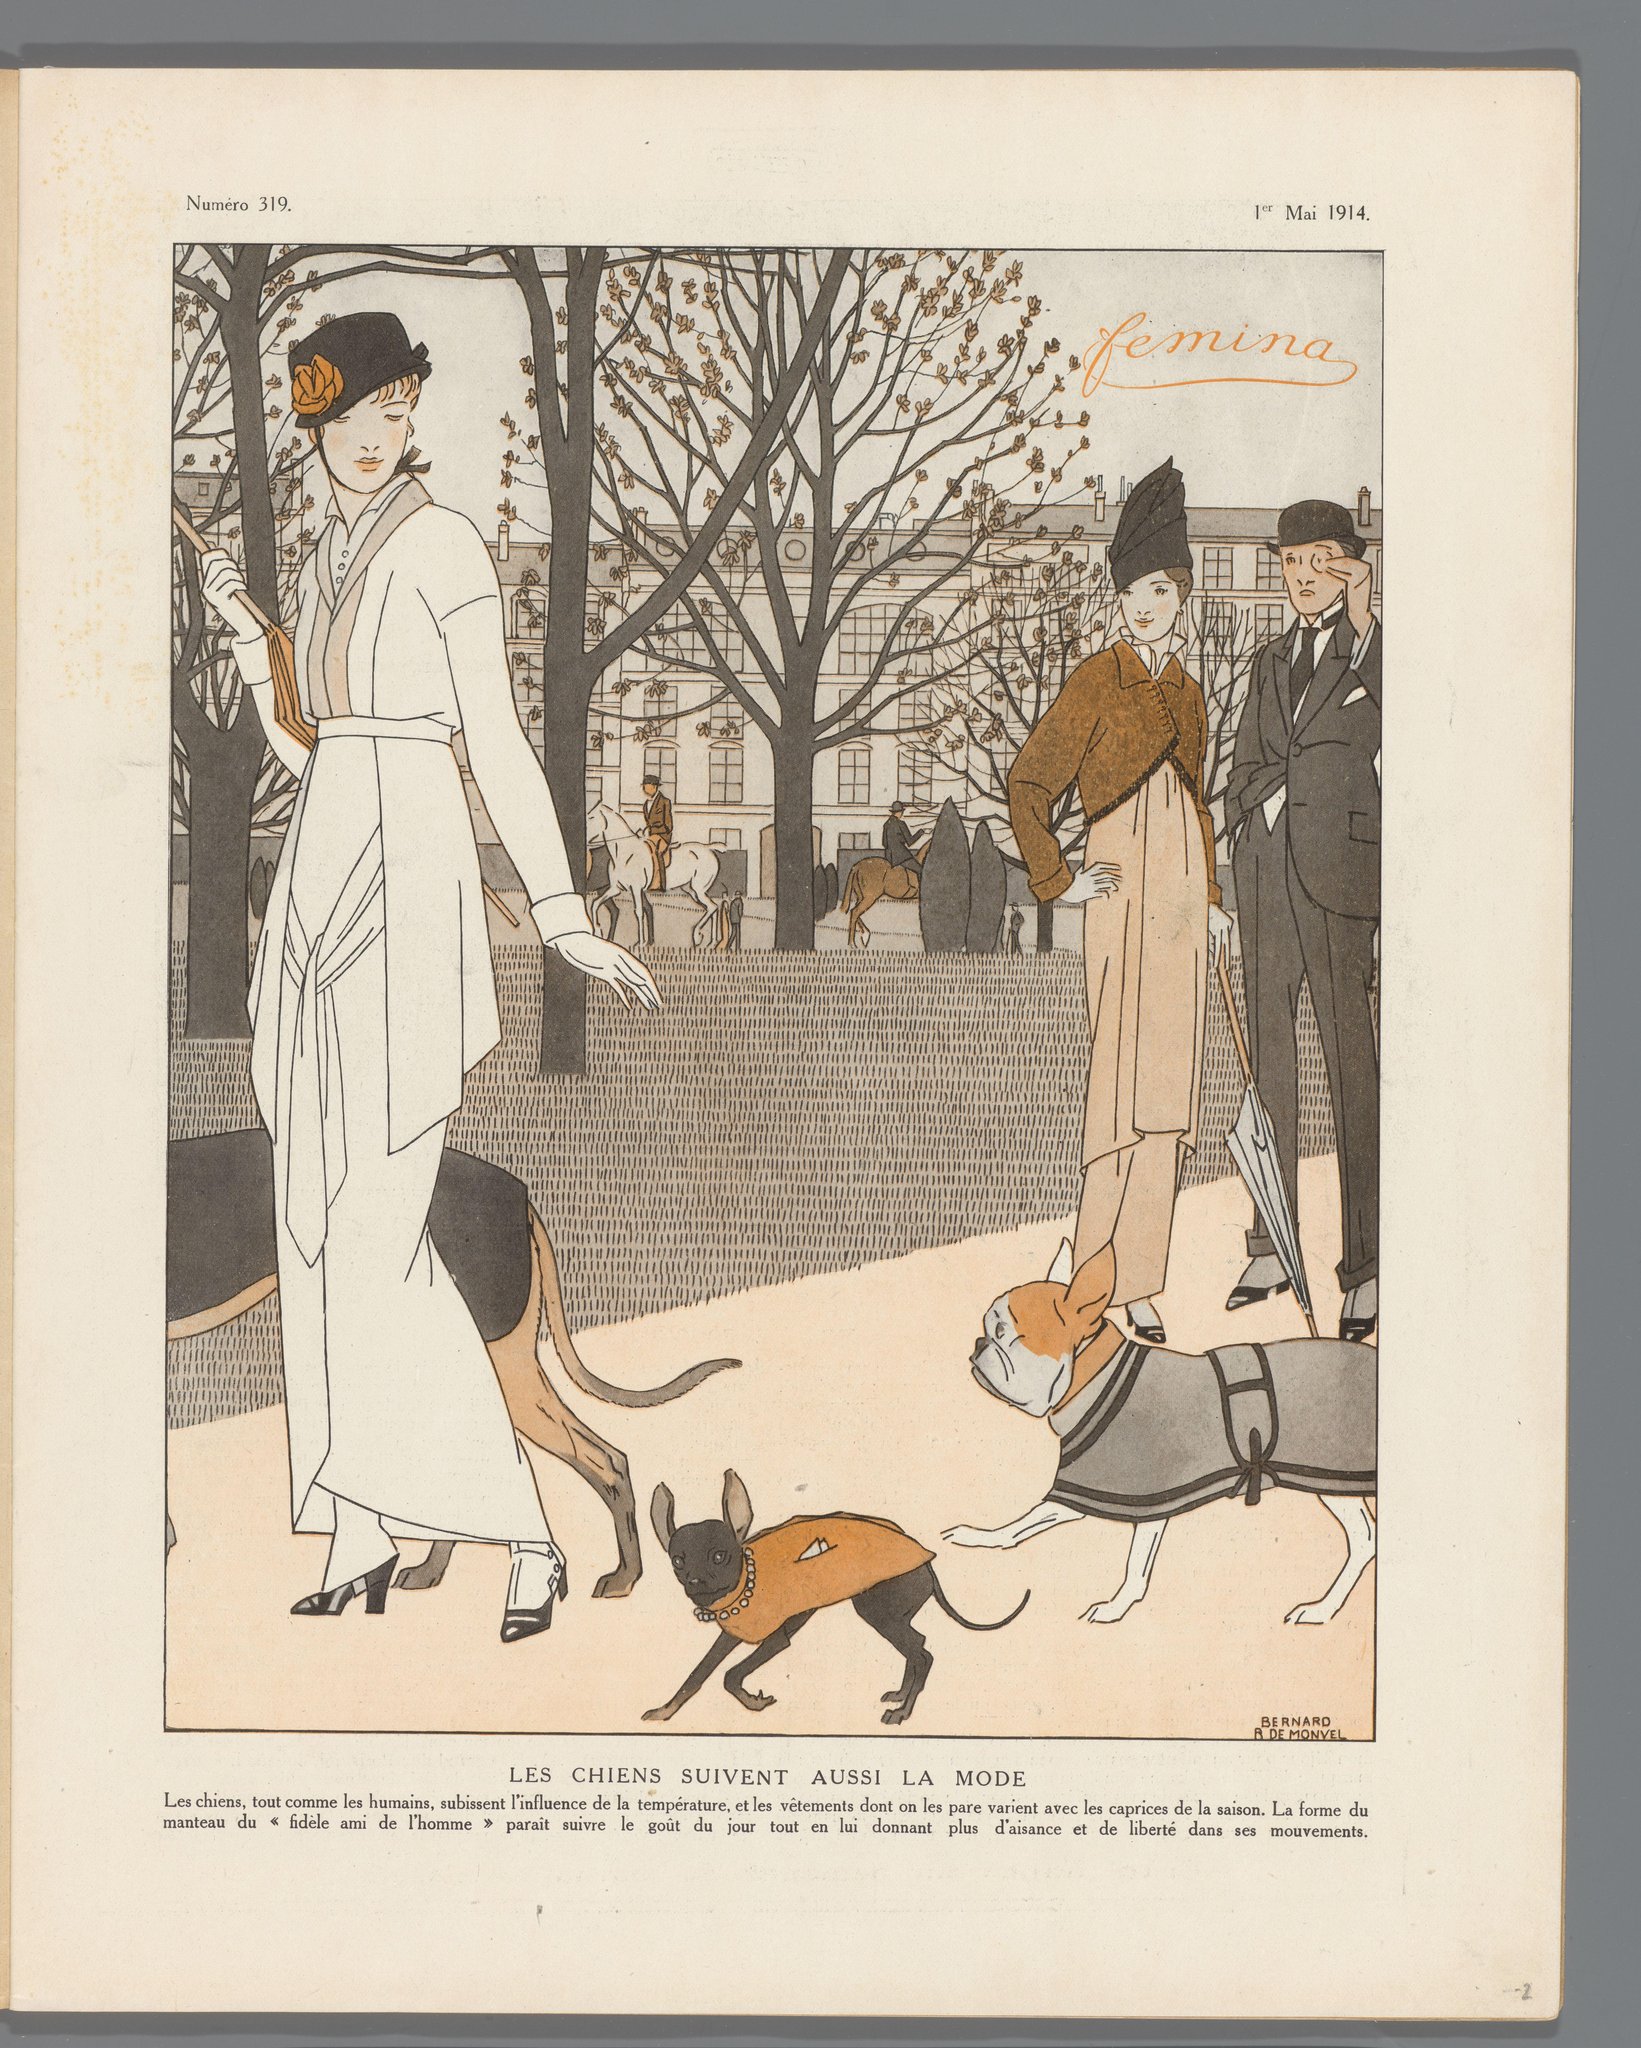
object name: fashion print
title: Femina, 1 Mai 1914, 14e Année, nr. 19: modeprent "Les chiens suivent aussi la mode"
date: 1914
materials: paper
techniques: photography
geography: paris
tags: fashion plates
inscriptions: title: ‘FEMINA’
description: Elegant geklede jonge vrouw, wandelend met haar honden die voorzien zijn van hondendeksjes naar de laatste mode. in: Modetijdschrift Femina. 14e Année, nr. 19: 1 Mai 1914.